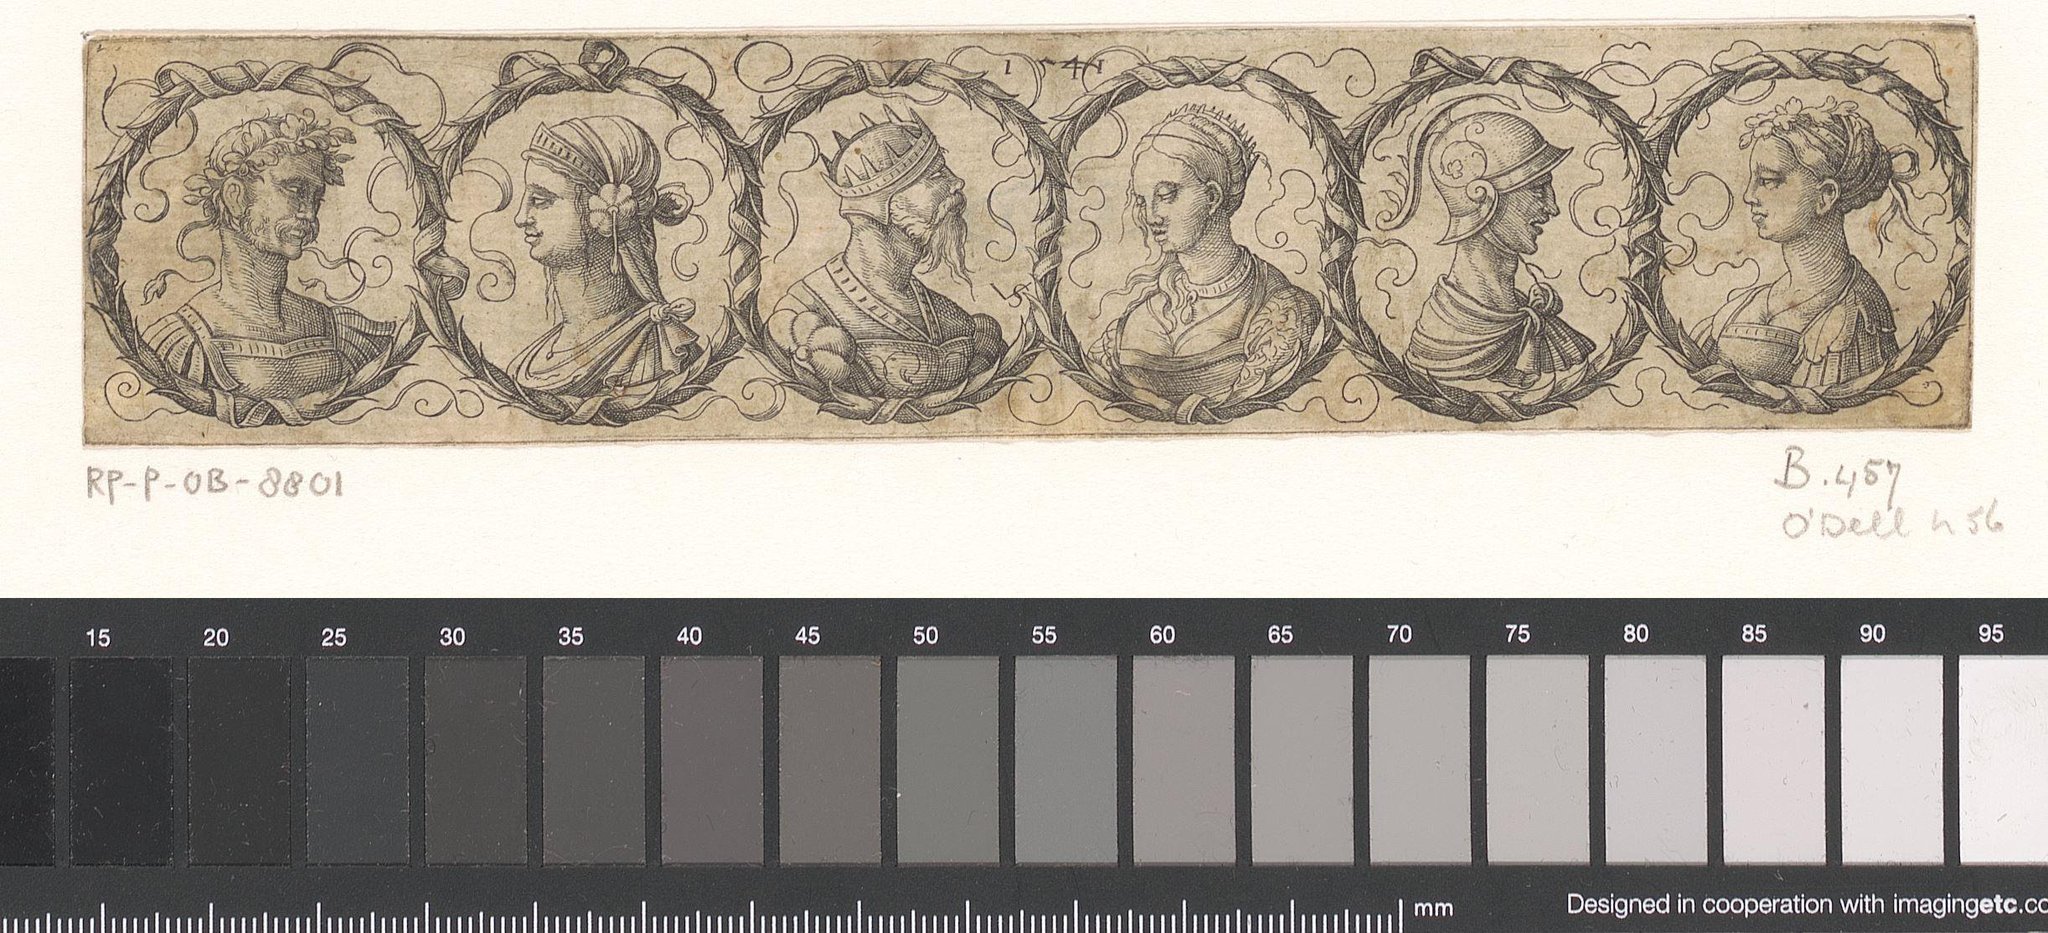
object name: print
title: Fries met zes bustes in lauwerkransen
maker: virgilius solis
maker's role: draughtsman, print maker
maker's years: 1514-1562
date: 1541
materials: paper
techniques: engraving, etching, intaglio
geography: nuremberg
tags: helmet, chest, bust, head-gear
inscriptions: collector's mark: Lugt 2228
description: Bustes van drie mannen en drie vrouwen, en profil en per twee naar elkaar gericht.